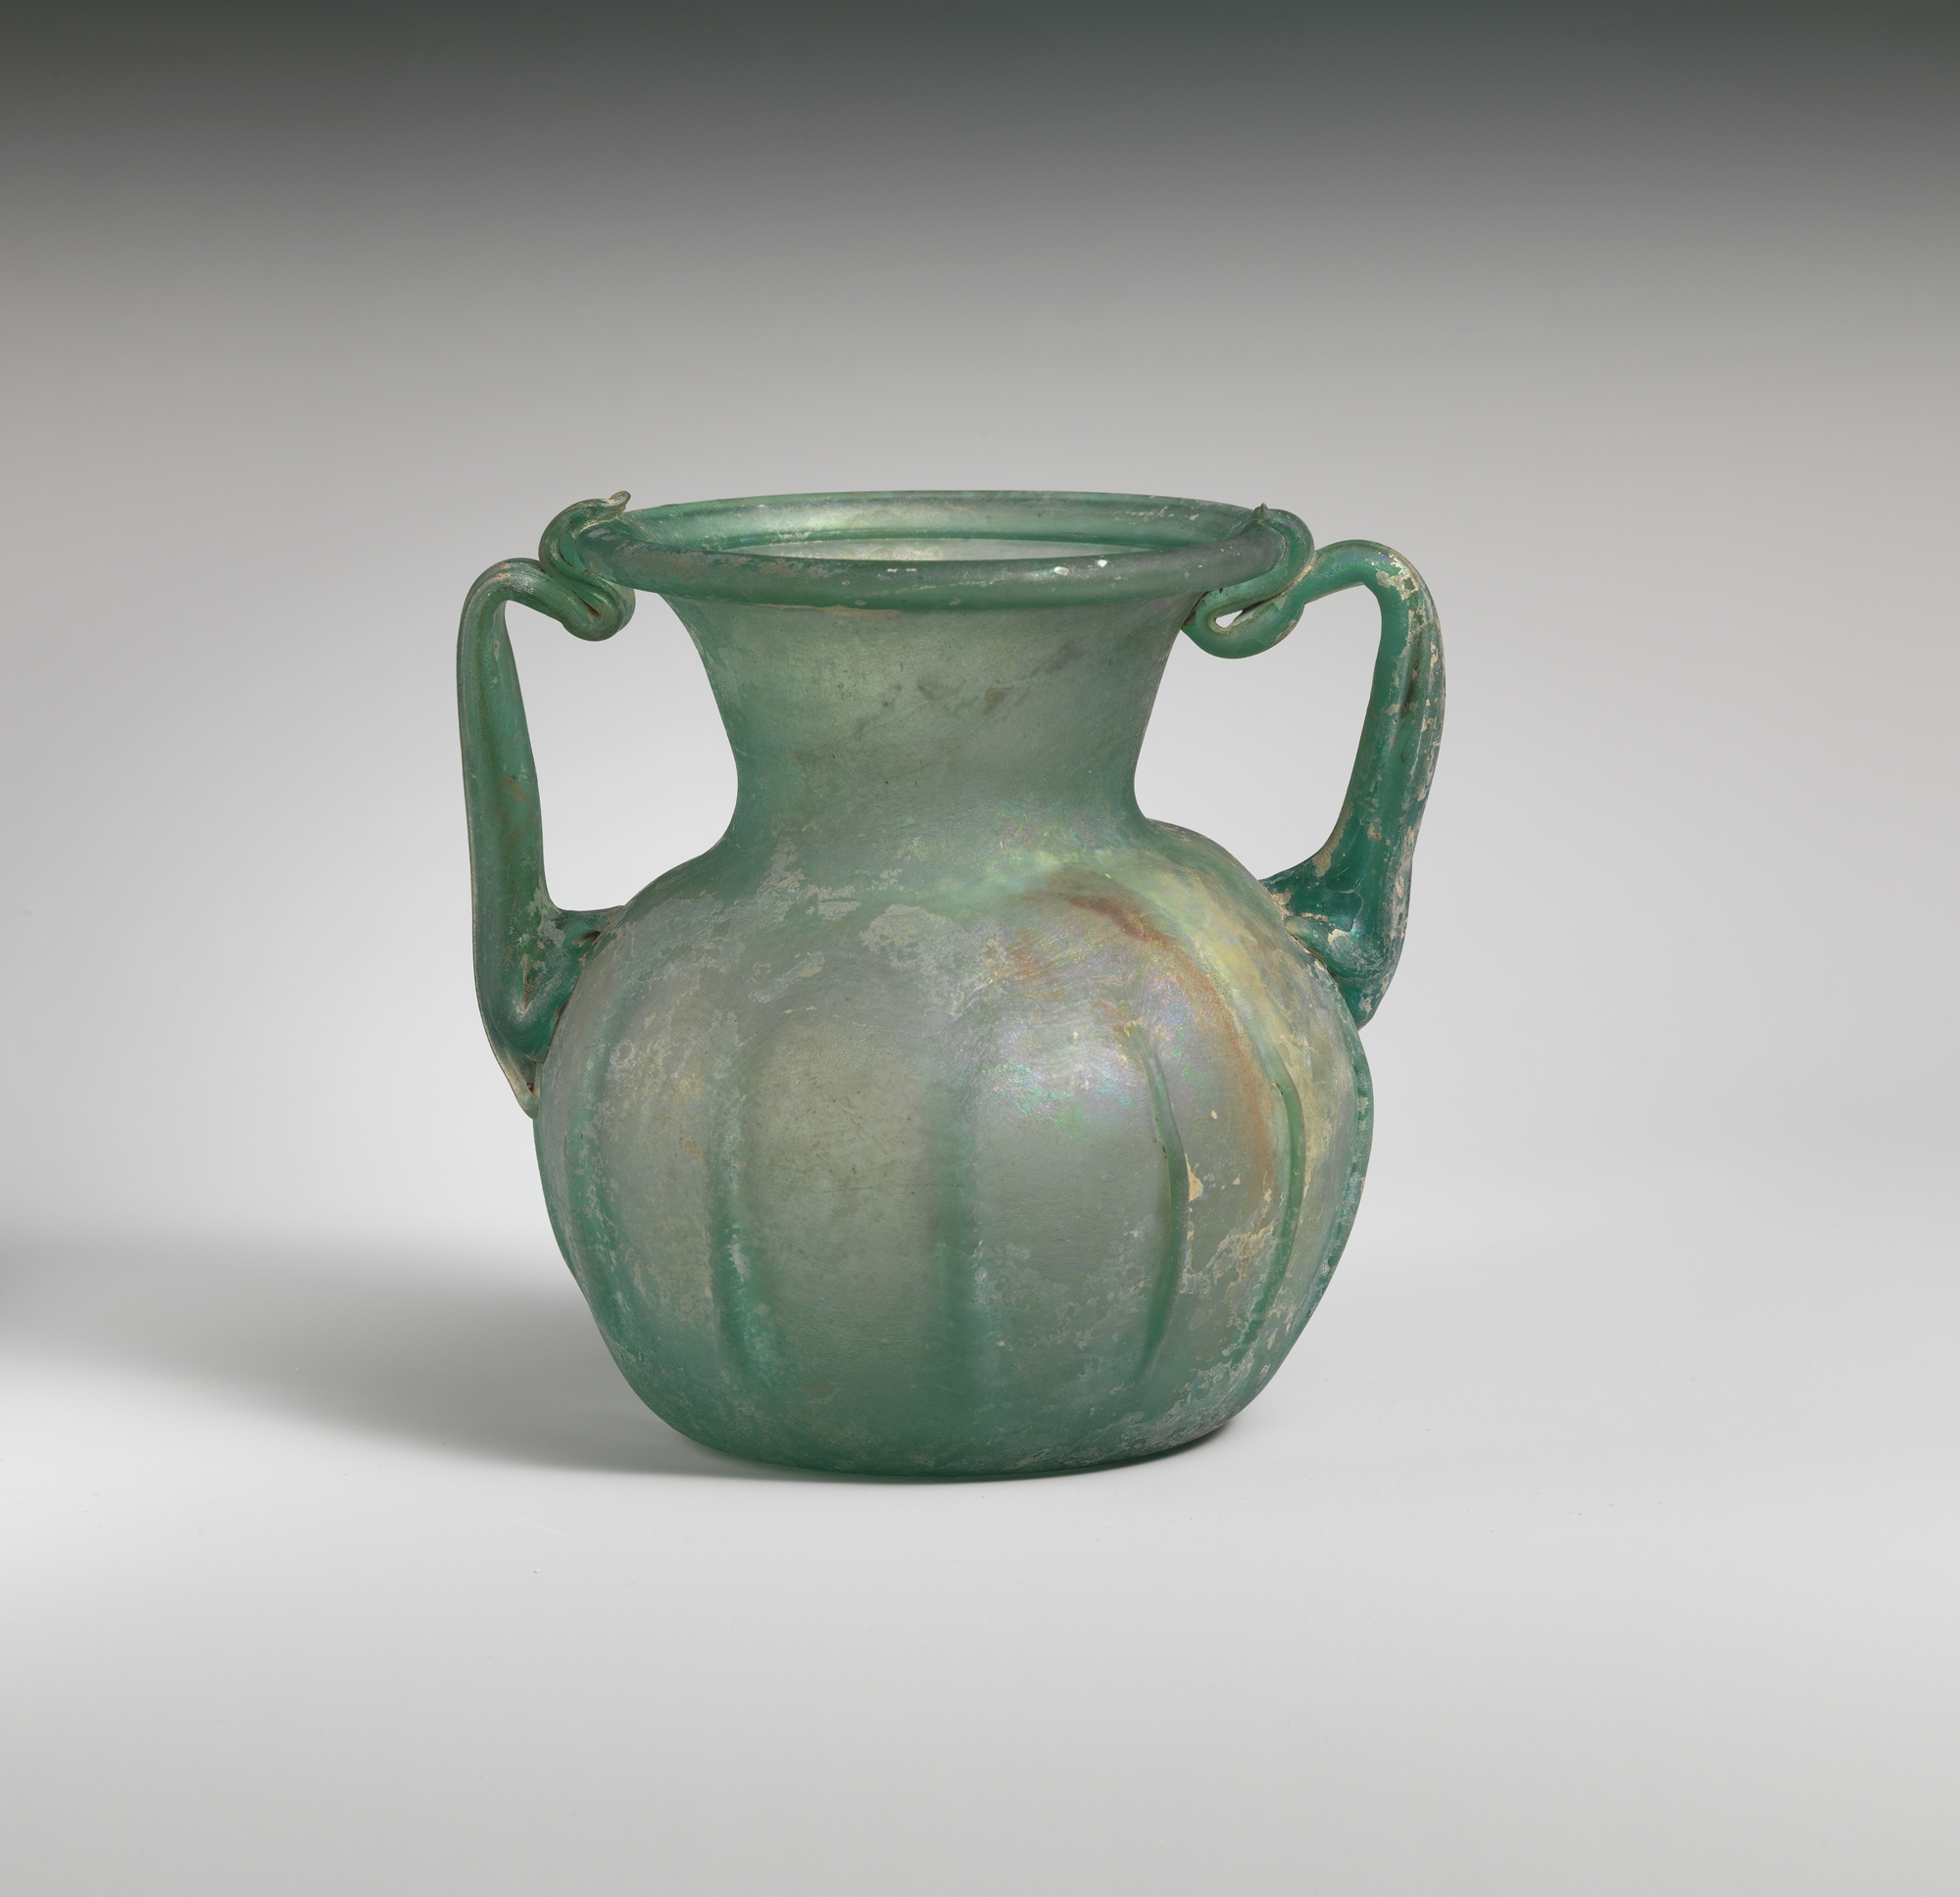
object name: jar with handle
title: Glass jar with two handles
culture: roman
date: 301-400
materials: glass